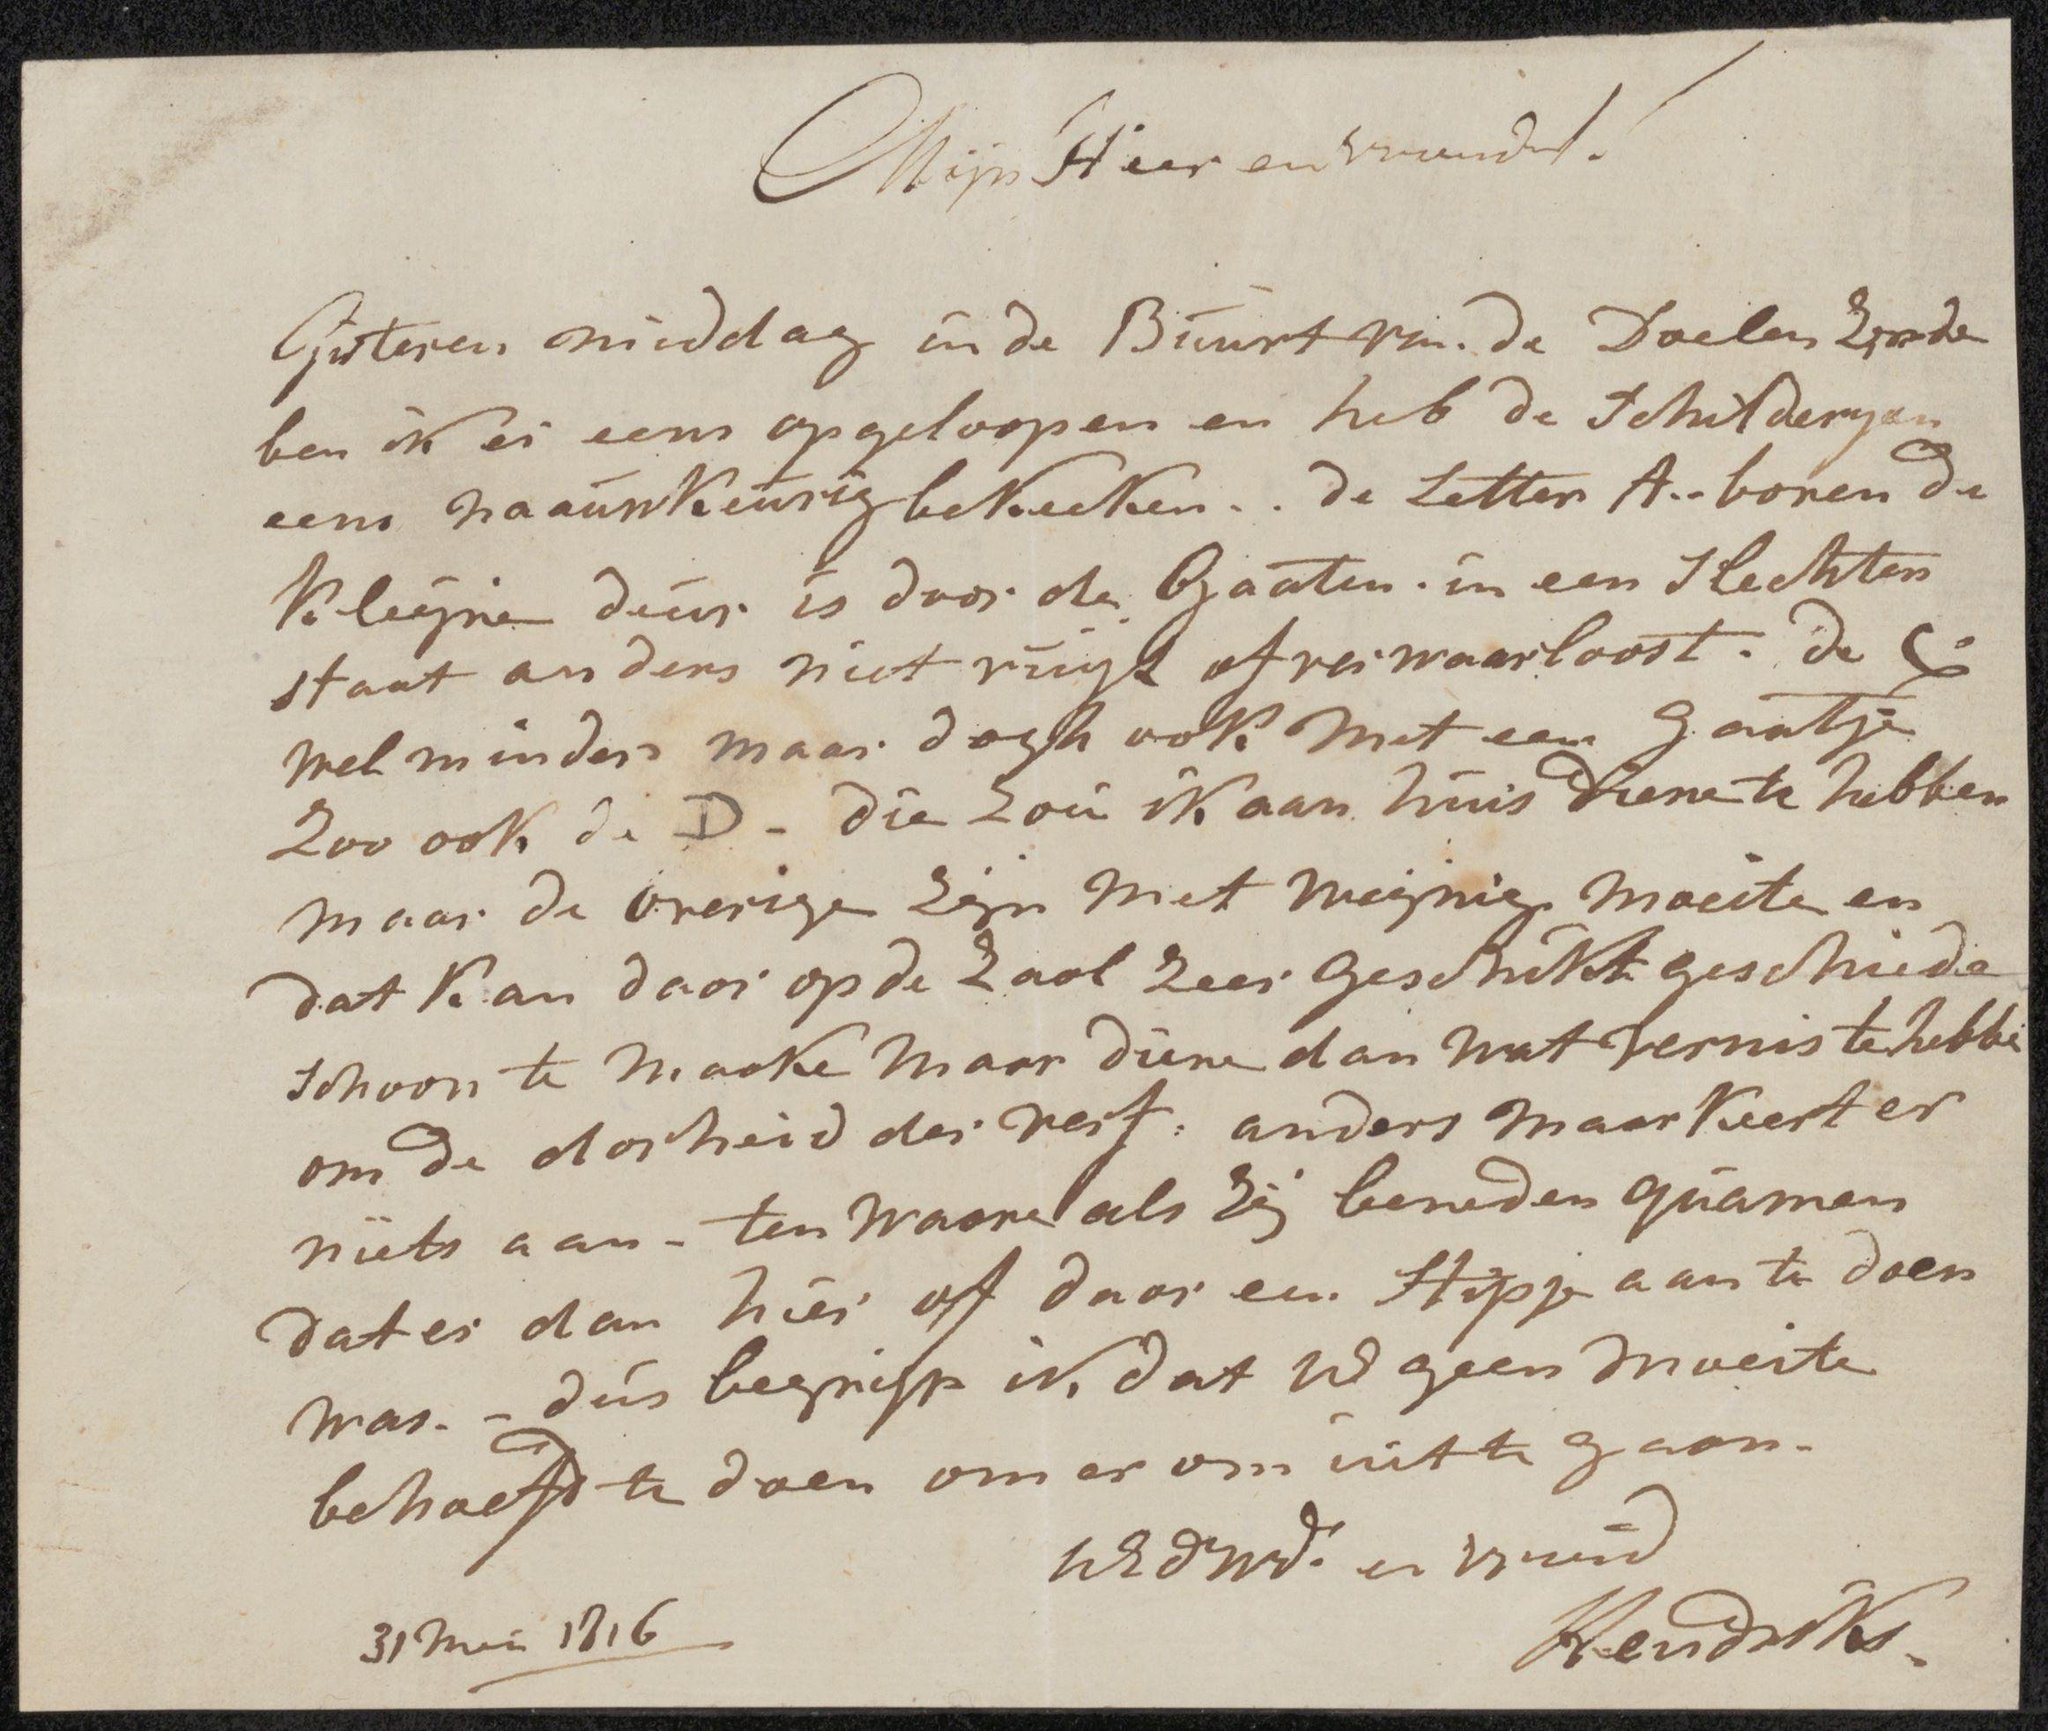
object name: letter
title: Brief aan Adriaan van der Willigen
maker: wybrand hendriks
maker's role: draughtsman, painter, print maker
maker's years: 1744-1831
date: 1816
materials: ink, paper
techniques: pen, writing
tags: rotterdam, haarlem, draughtsman, adriaan van der willigen, painting (including book-illumination, miniature-painting)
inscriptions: watermark